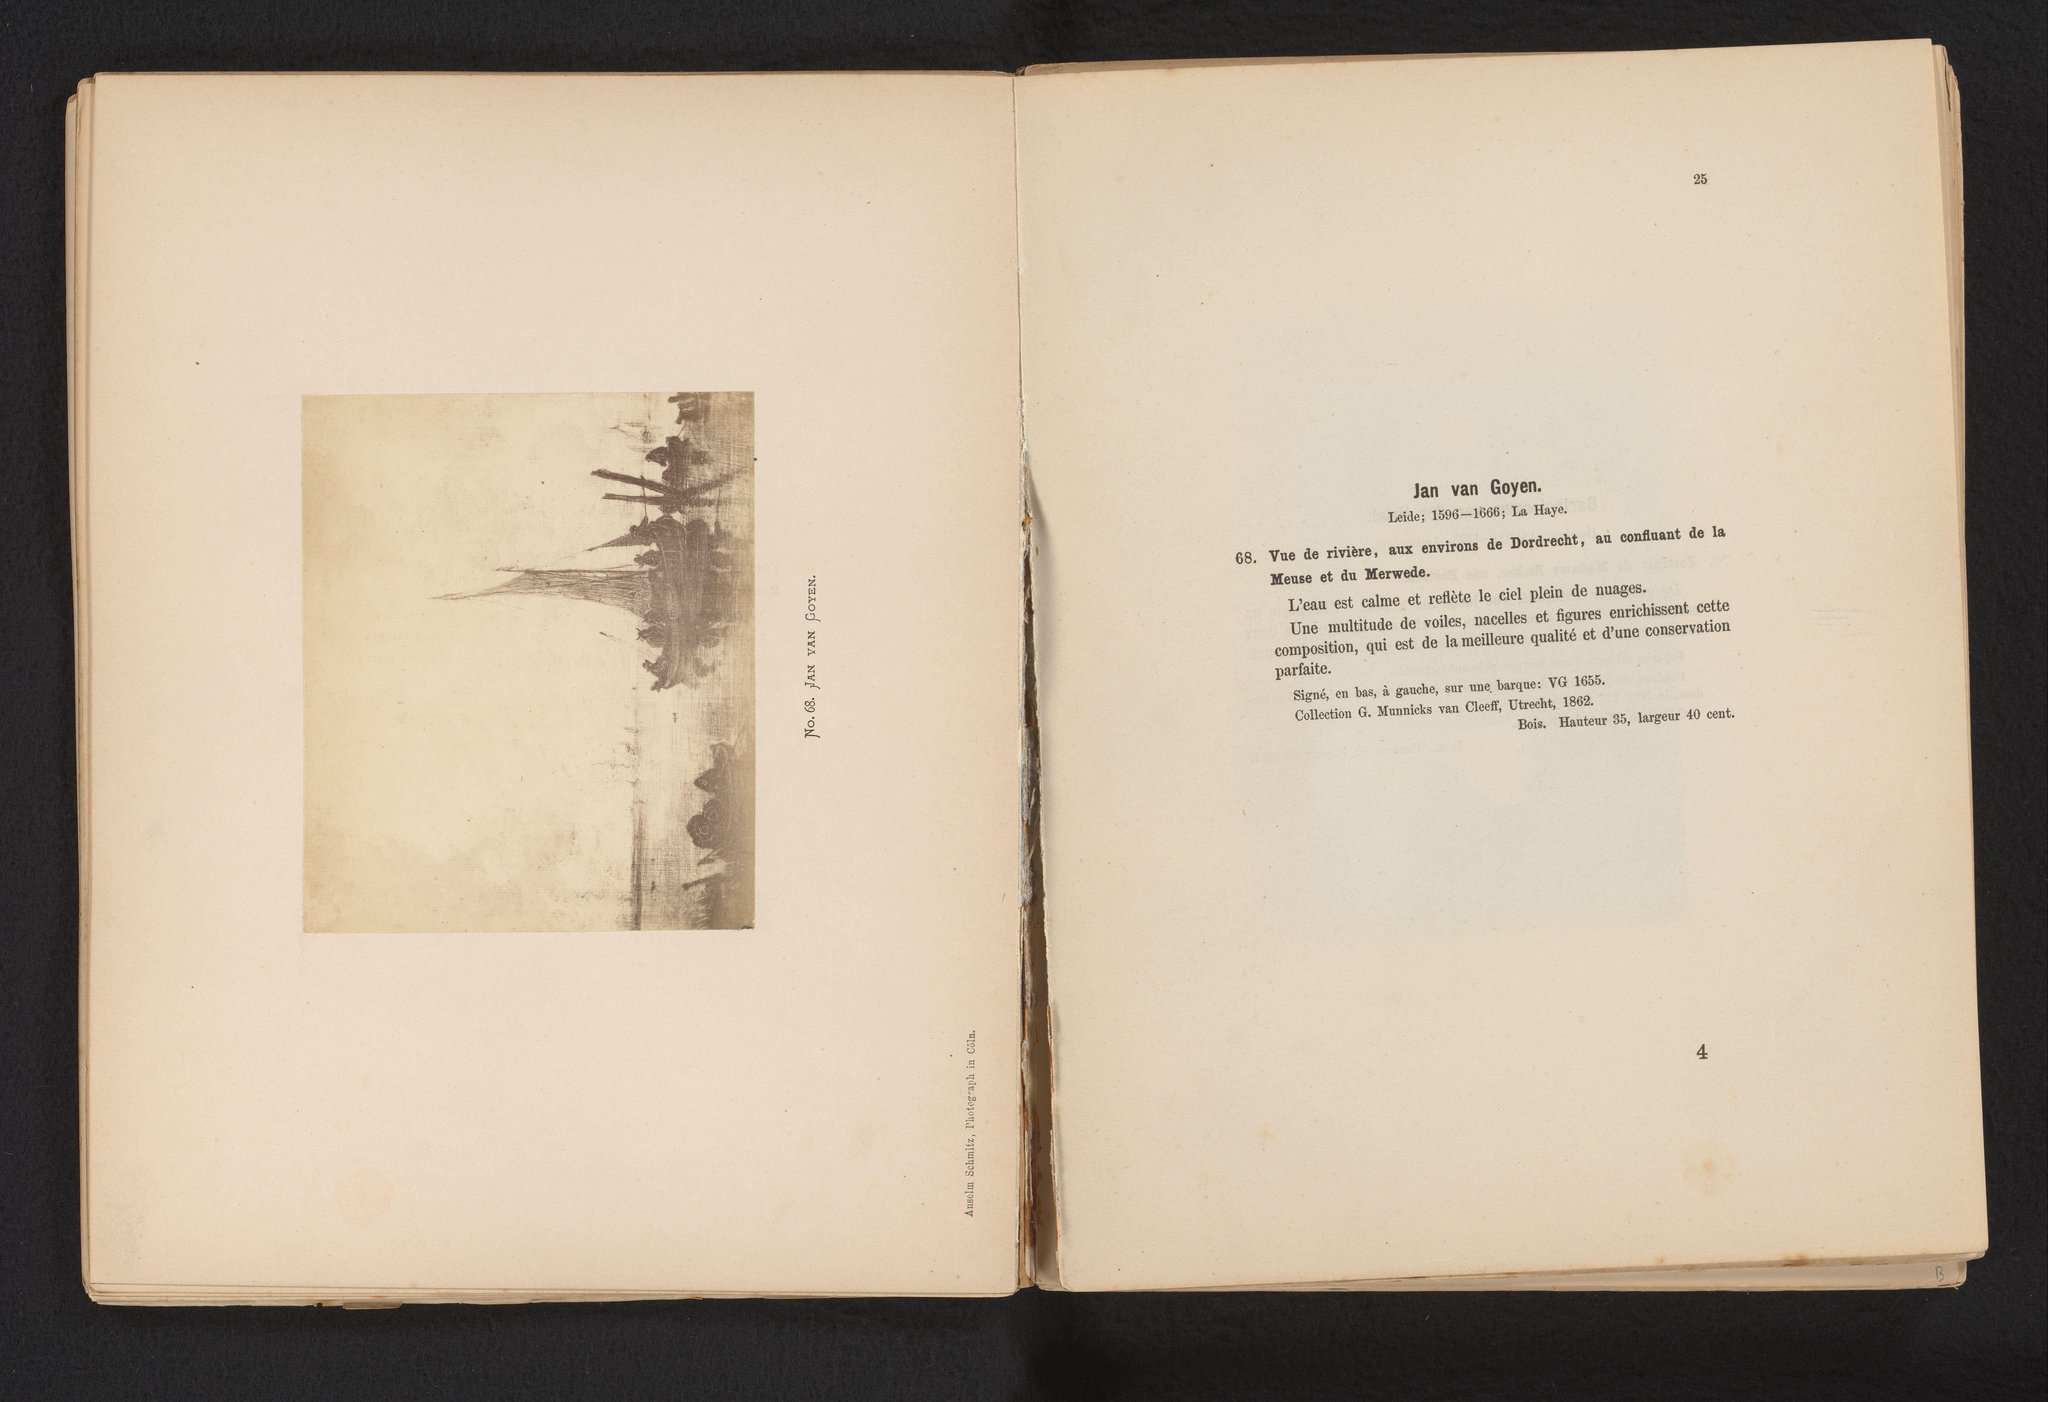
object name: page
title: Fotoreproductie van een schilderij van een rivierlandschap nabij Dordrecht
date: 1871-1876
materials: photographic support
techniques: albumen print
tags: sailing-ship, sailing-boat, landscapes with waters, waterscapes, seascapes (in the temperate zone)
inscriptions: inscription: ‘No. 68. Jan van Goyen’